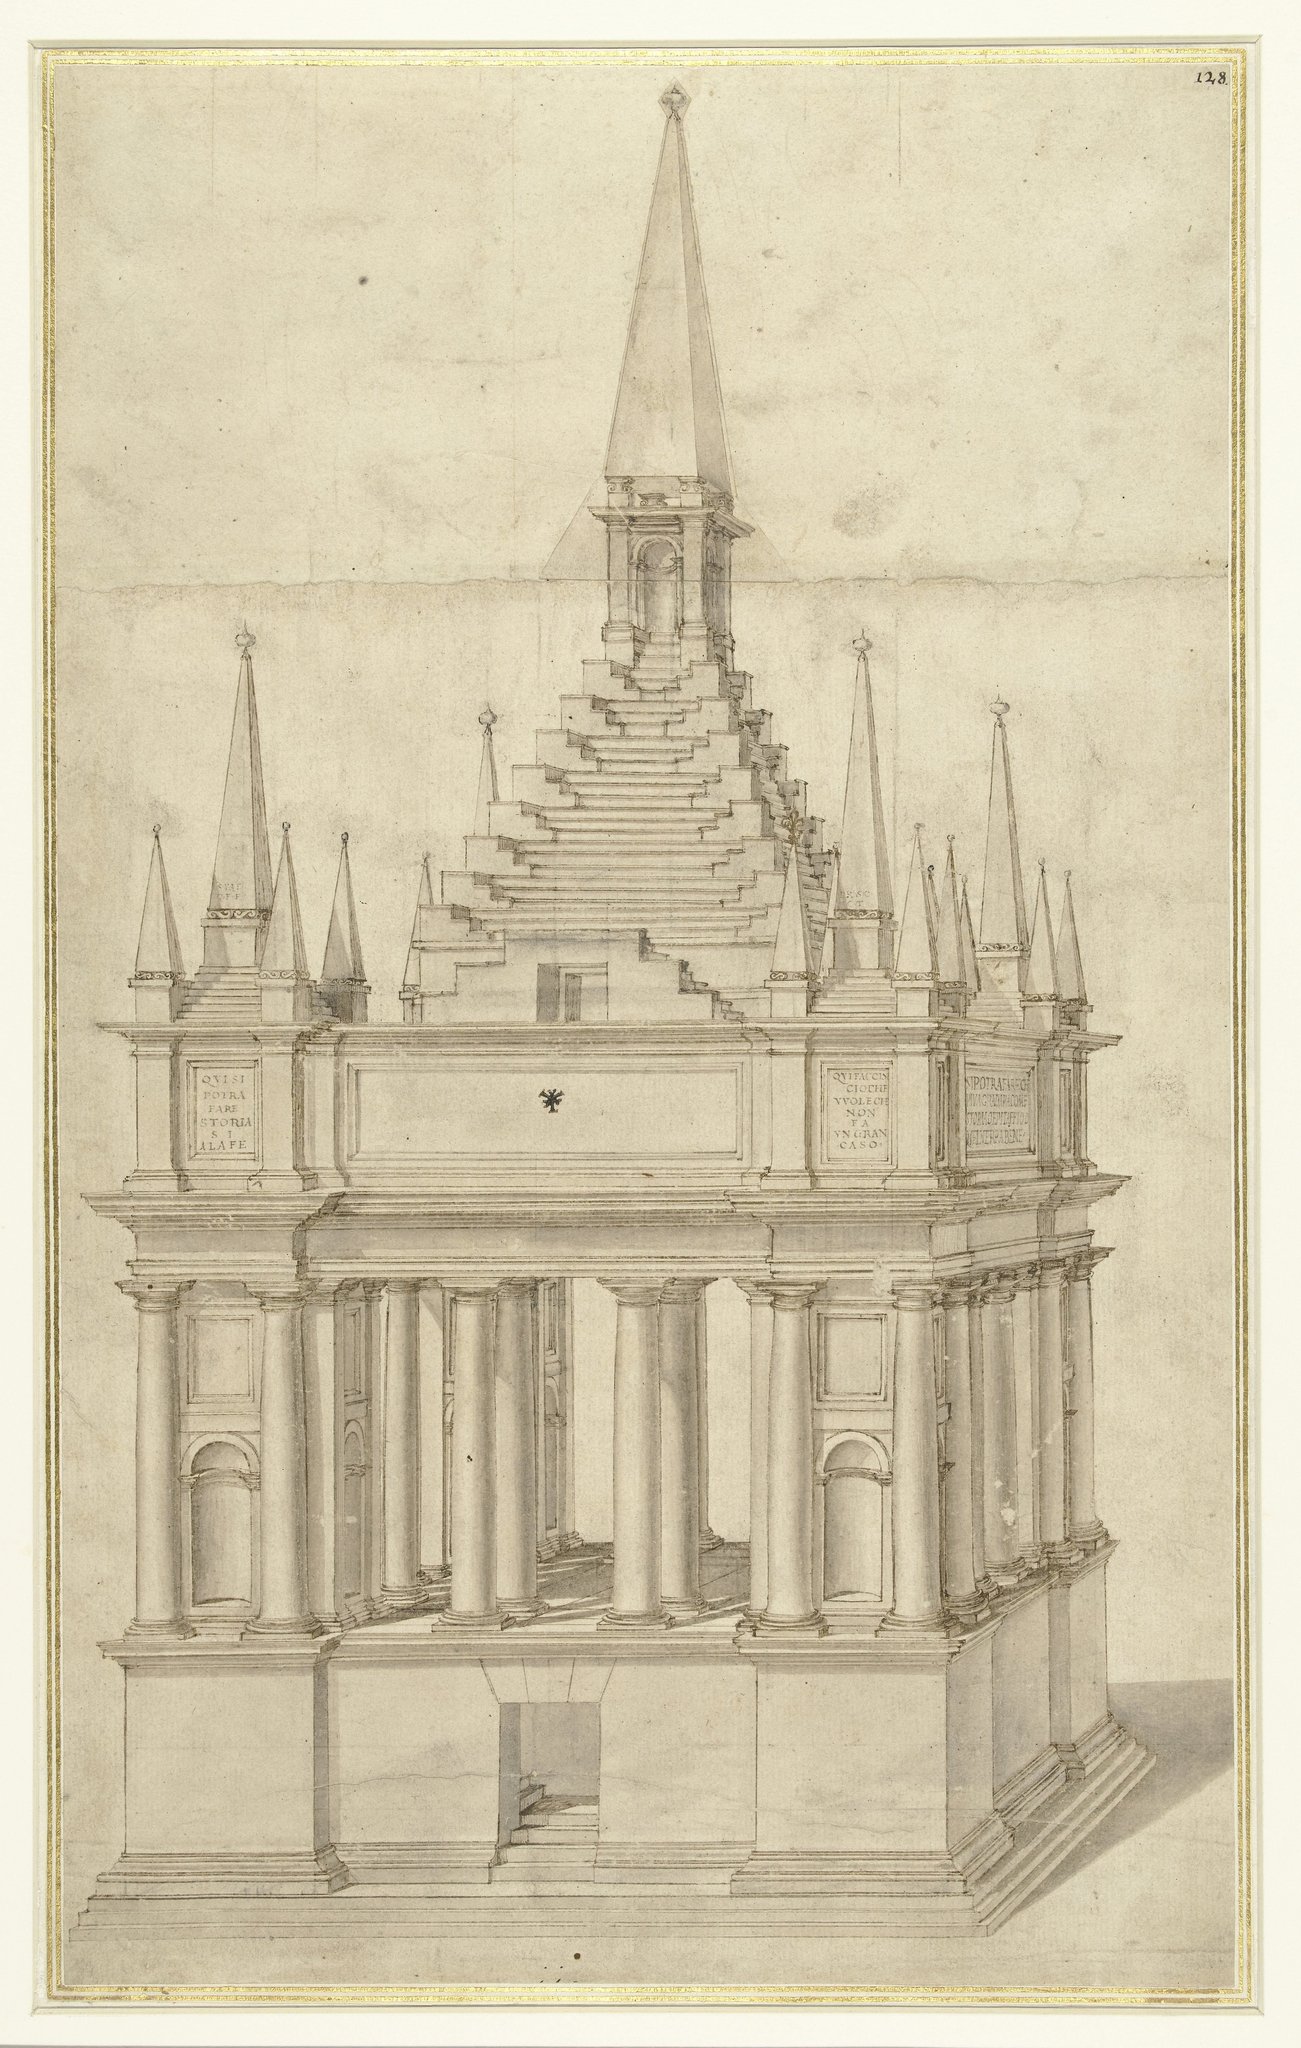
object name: design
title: Ontwerp voor een grafmonument of tabernakel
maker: Anonymous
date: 1530-1570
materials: ink, paper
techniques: brush, pen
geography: italy